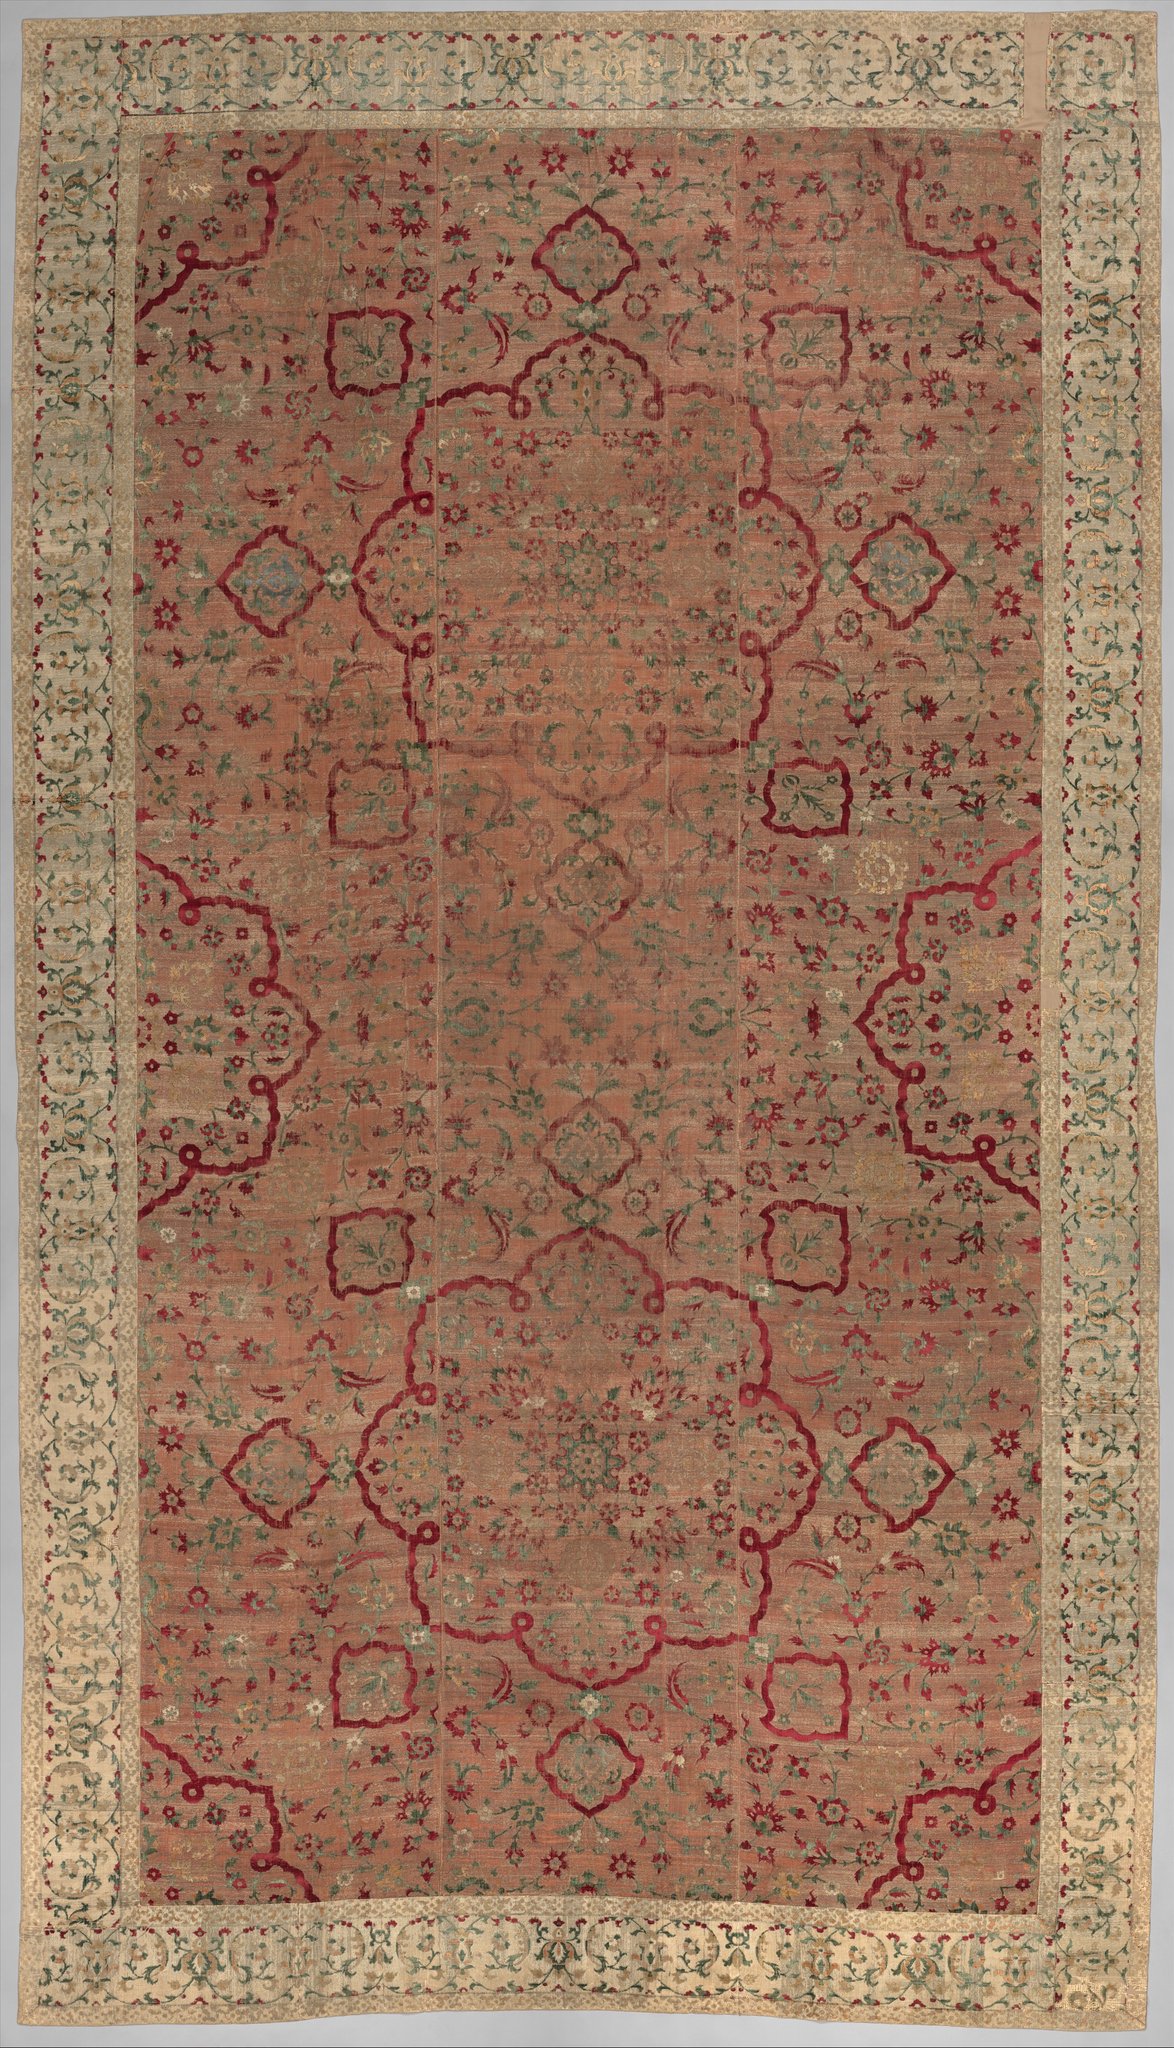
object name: carpet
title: Velvet and Silk Carpet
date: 1601-1700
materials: metal thread, silk, velvet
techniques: brocade, cutting, voiding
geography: india